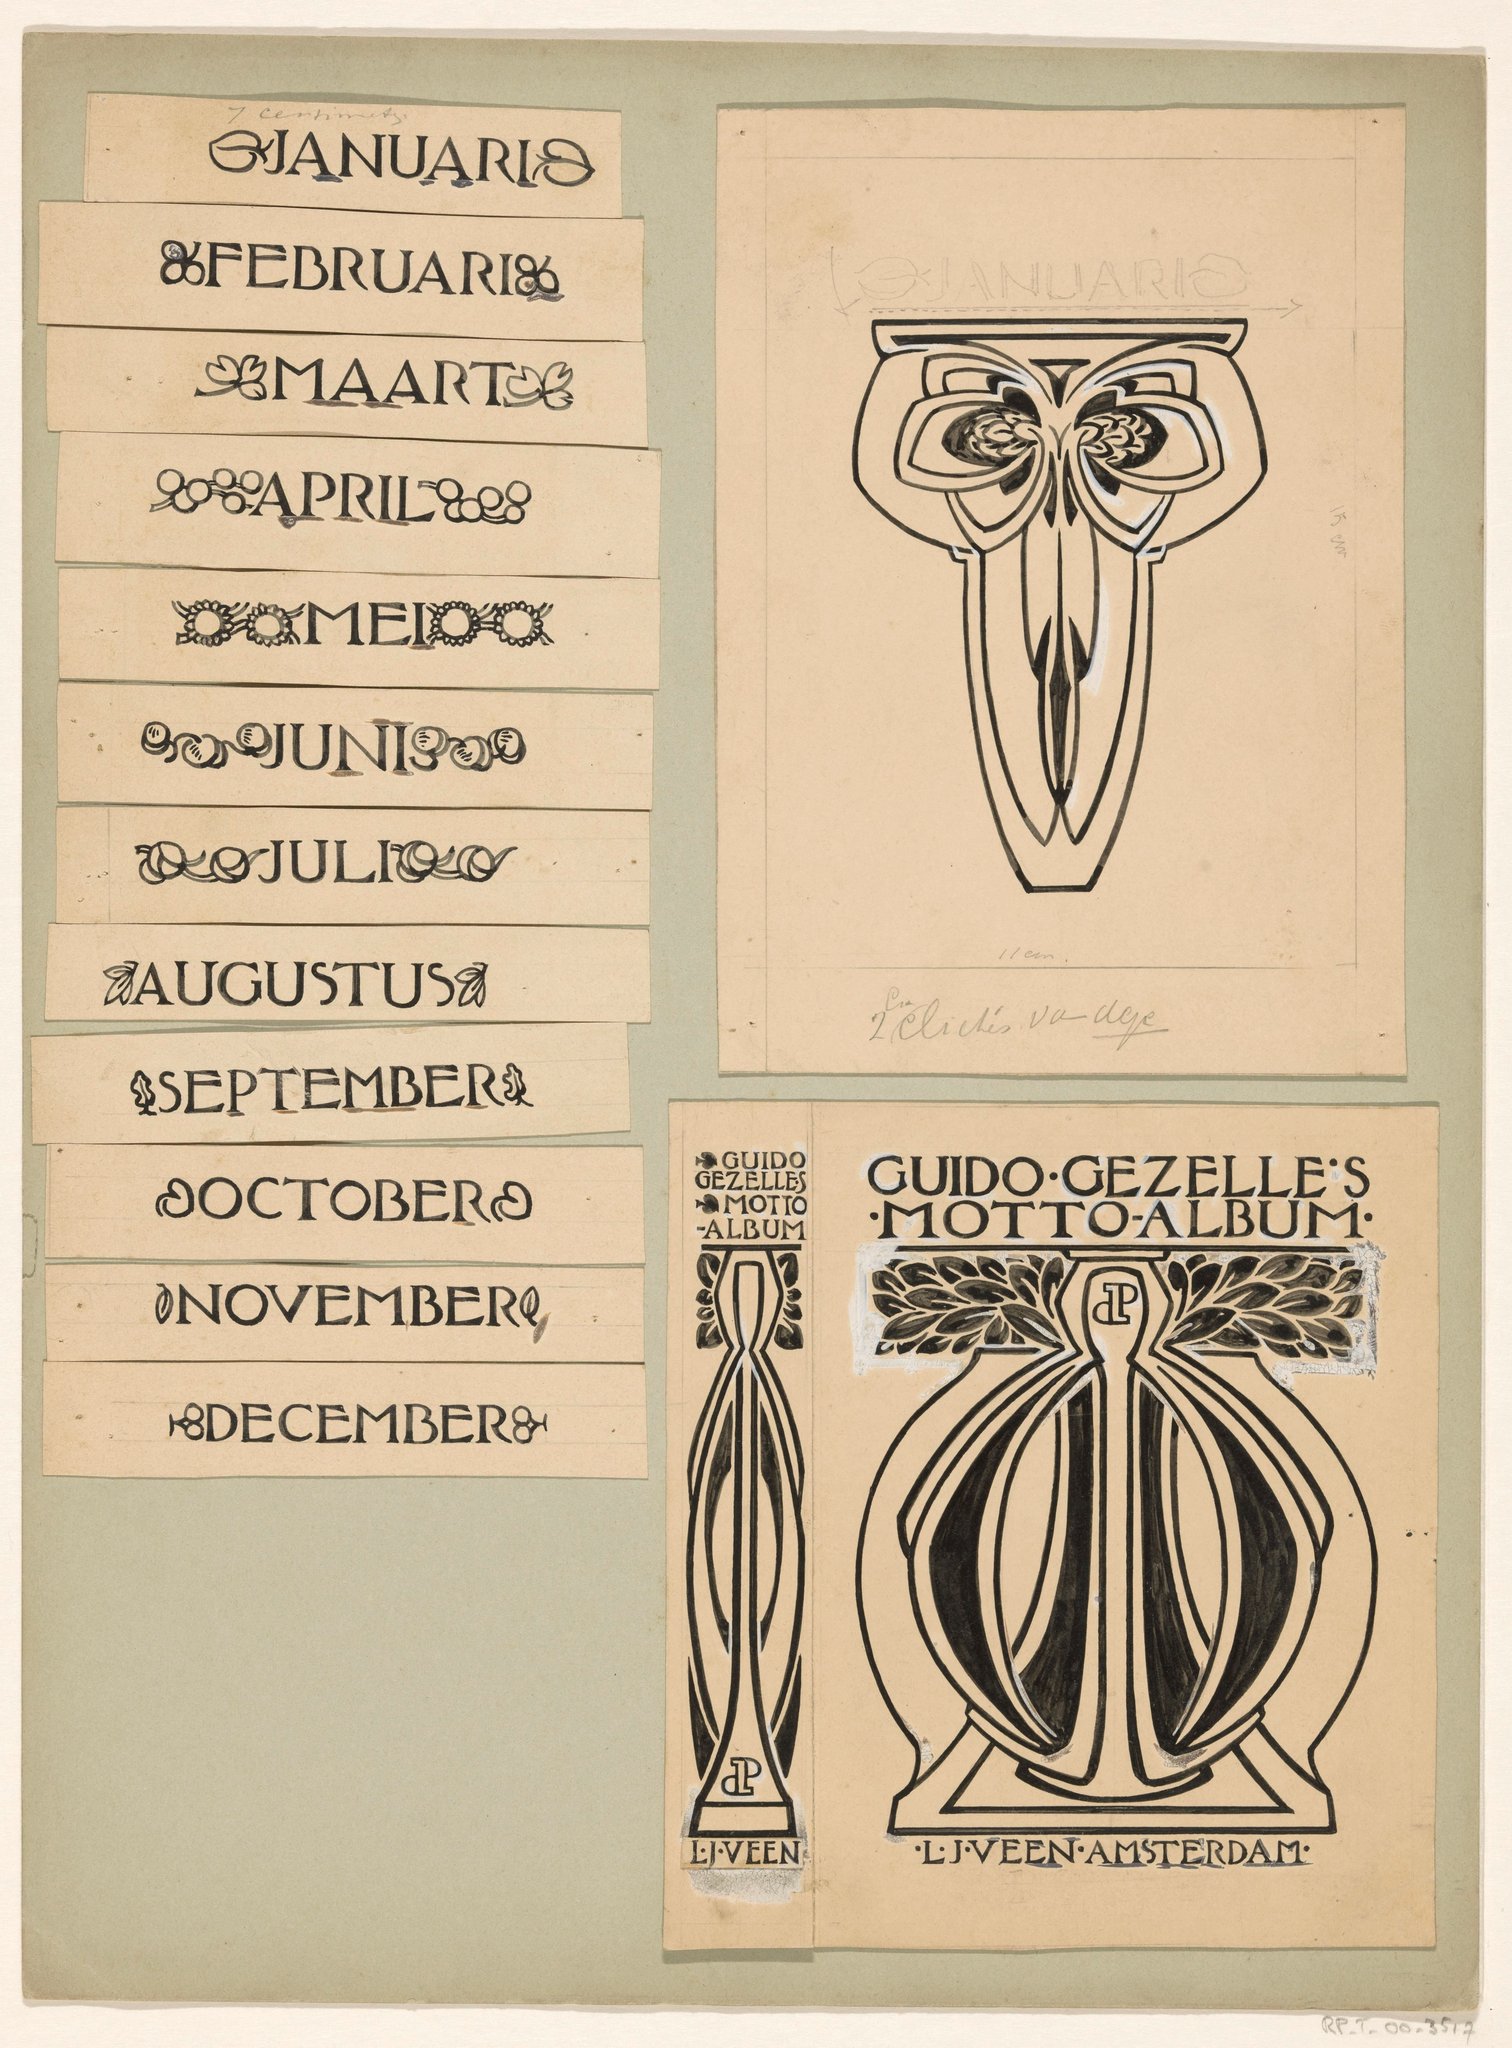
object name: boekillustratie ontwerp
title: Bandontwerp en illustraties voor: Guido Gezelle, Motto-album, 1904-1919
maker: jules de praetere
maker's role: draughtsman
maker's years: 1879-1947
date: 1904-1919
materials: cardboard, paint, ink, paper, pencil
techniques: brush, pen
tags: ornaments ~ art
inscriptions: :, collector's mark: Lugt 2228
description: Bandontwerp en boekillustratie met ornament en (bloem)bladeren. Tevens ontwerpen voor de maanden van het jaar voorzien van onder andere bloem- en bladornamenten.